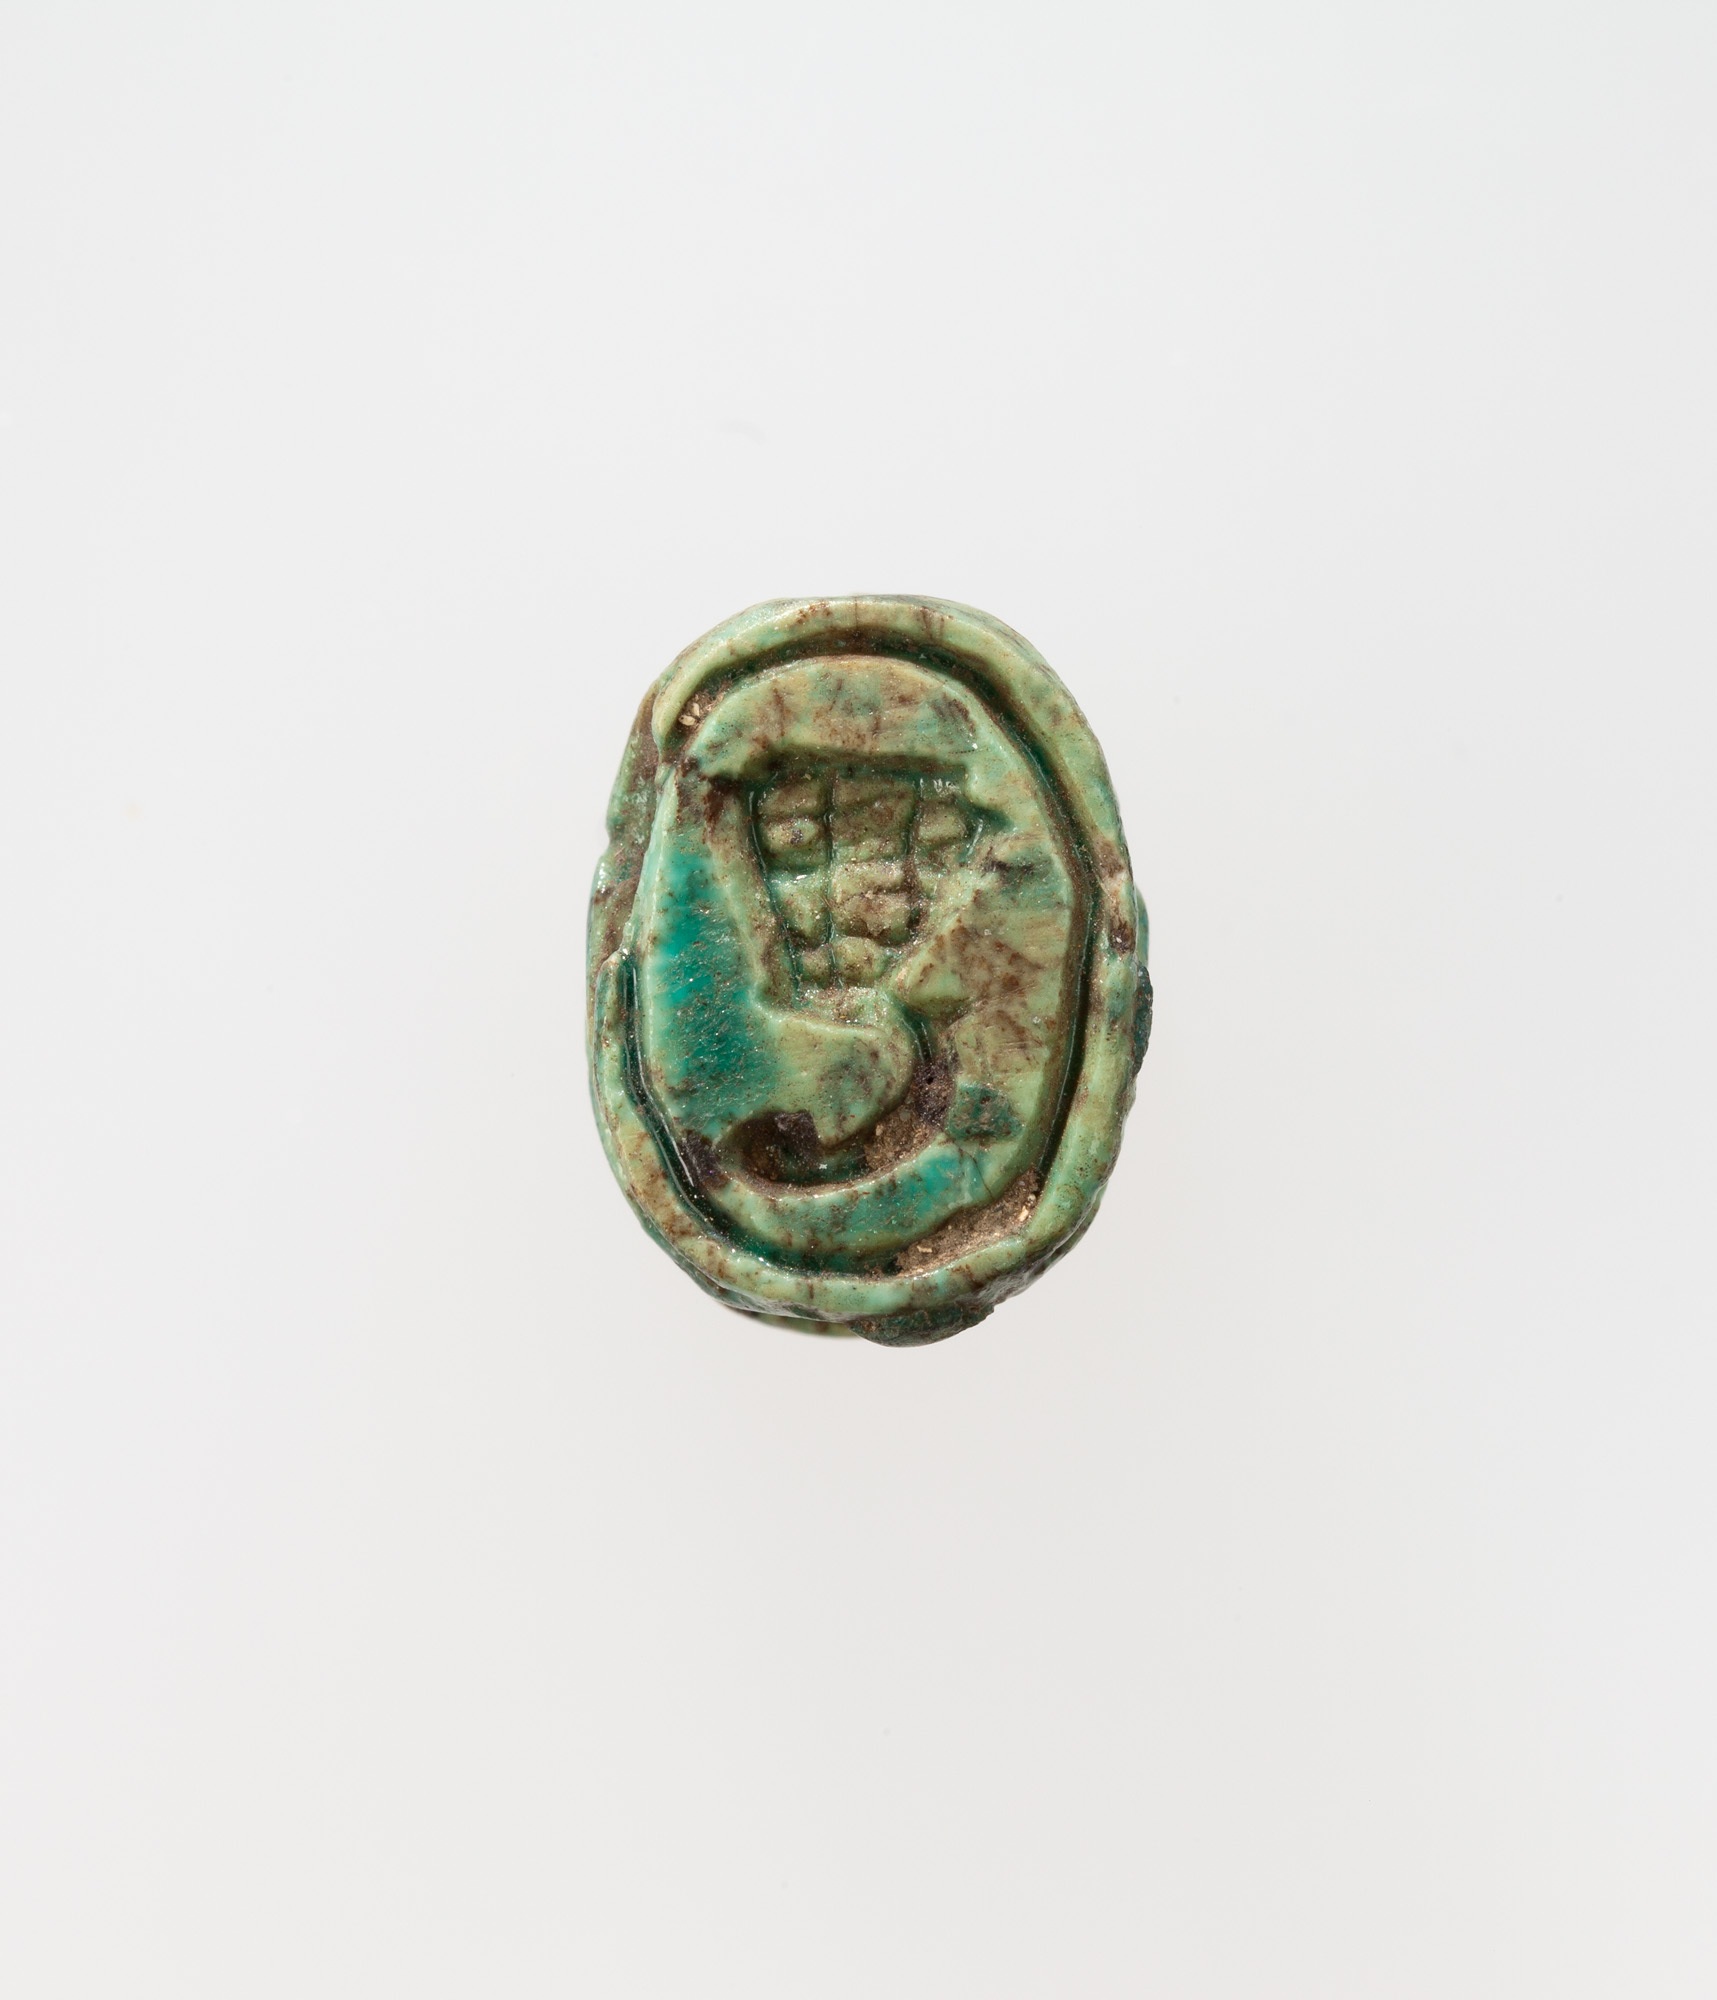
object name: scarab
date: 1479-1458 BCE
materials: faience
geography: egypt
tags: scarabs